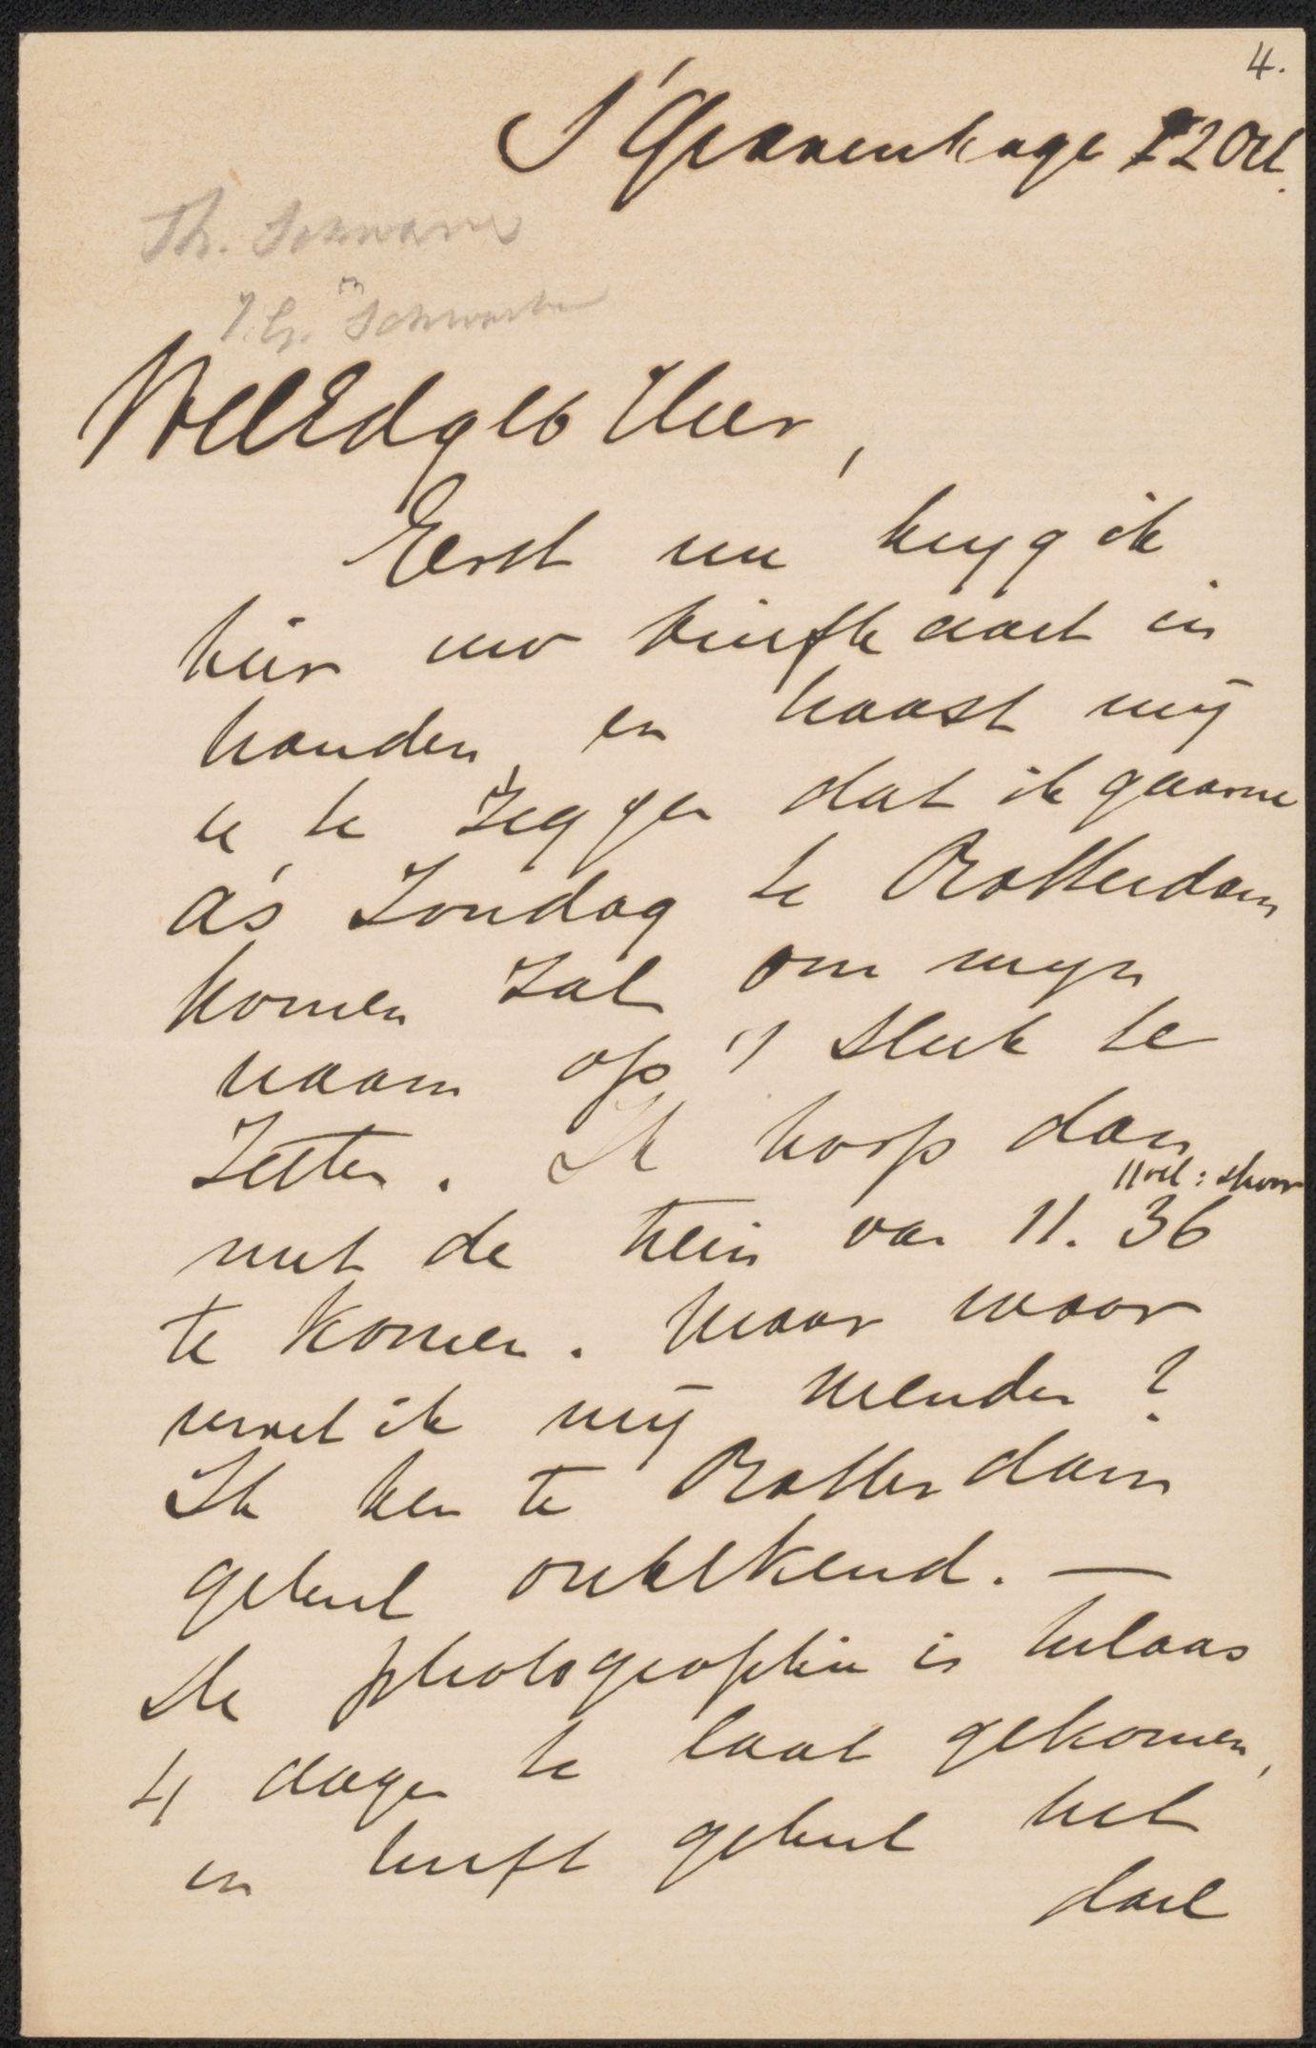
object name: letter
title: Brief aan anoniem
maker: thérèse schwartze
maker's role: draughtsman, painter, print maker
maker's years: 1851-1918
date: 1861-1915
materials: ink, paper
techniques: pen, writing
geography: the hague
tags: drawing, photography, cinematography, painting (including book-illumination, miniature-painting), the hague, rotterdam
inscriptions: watermark